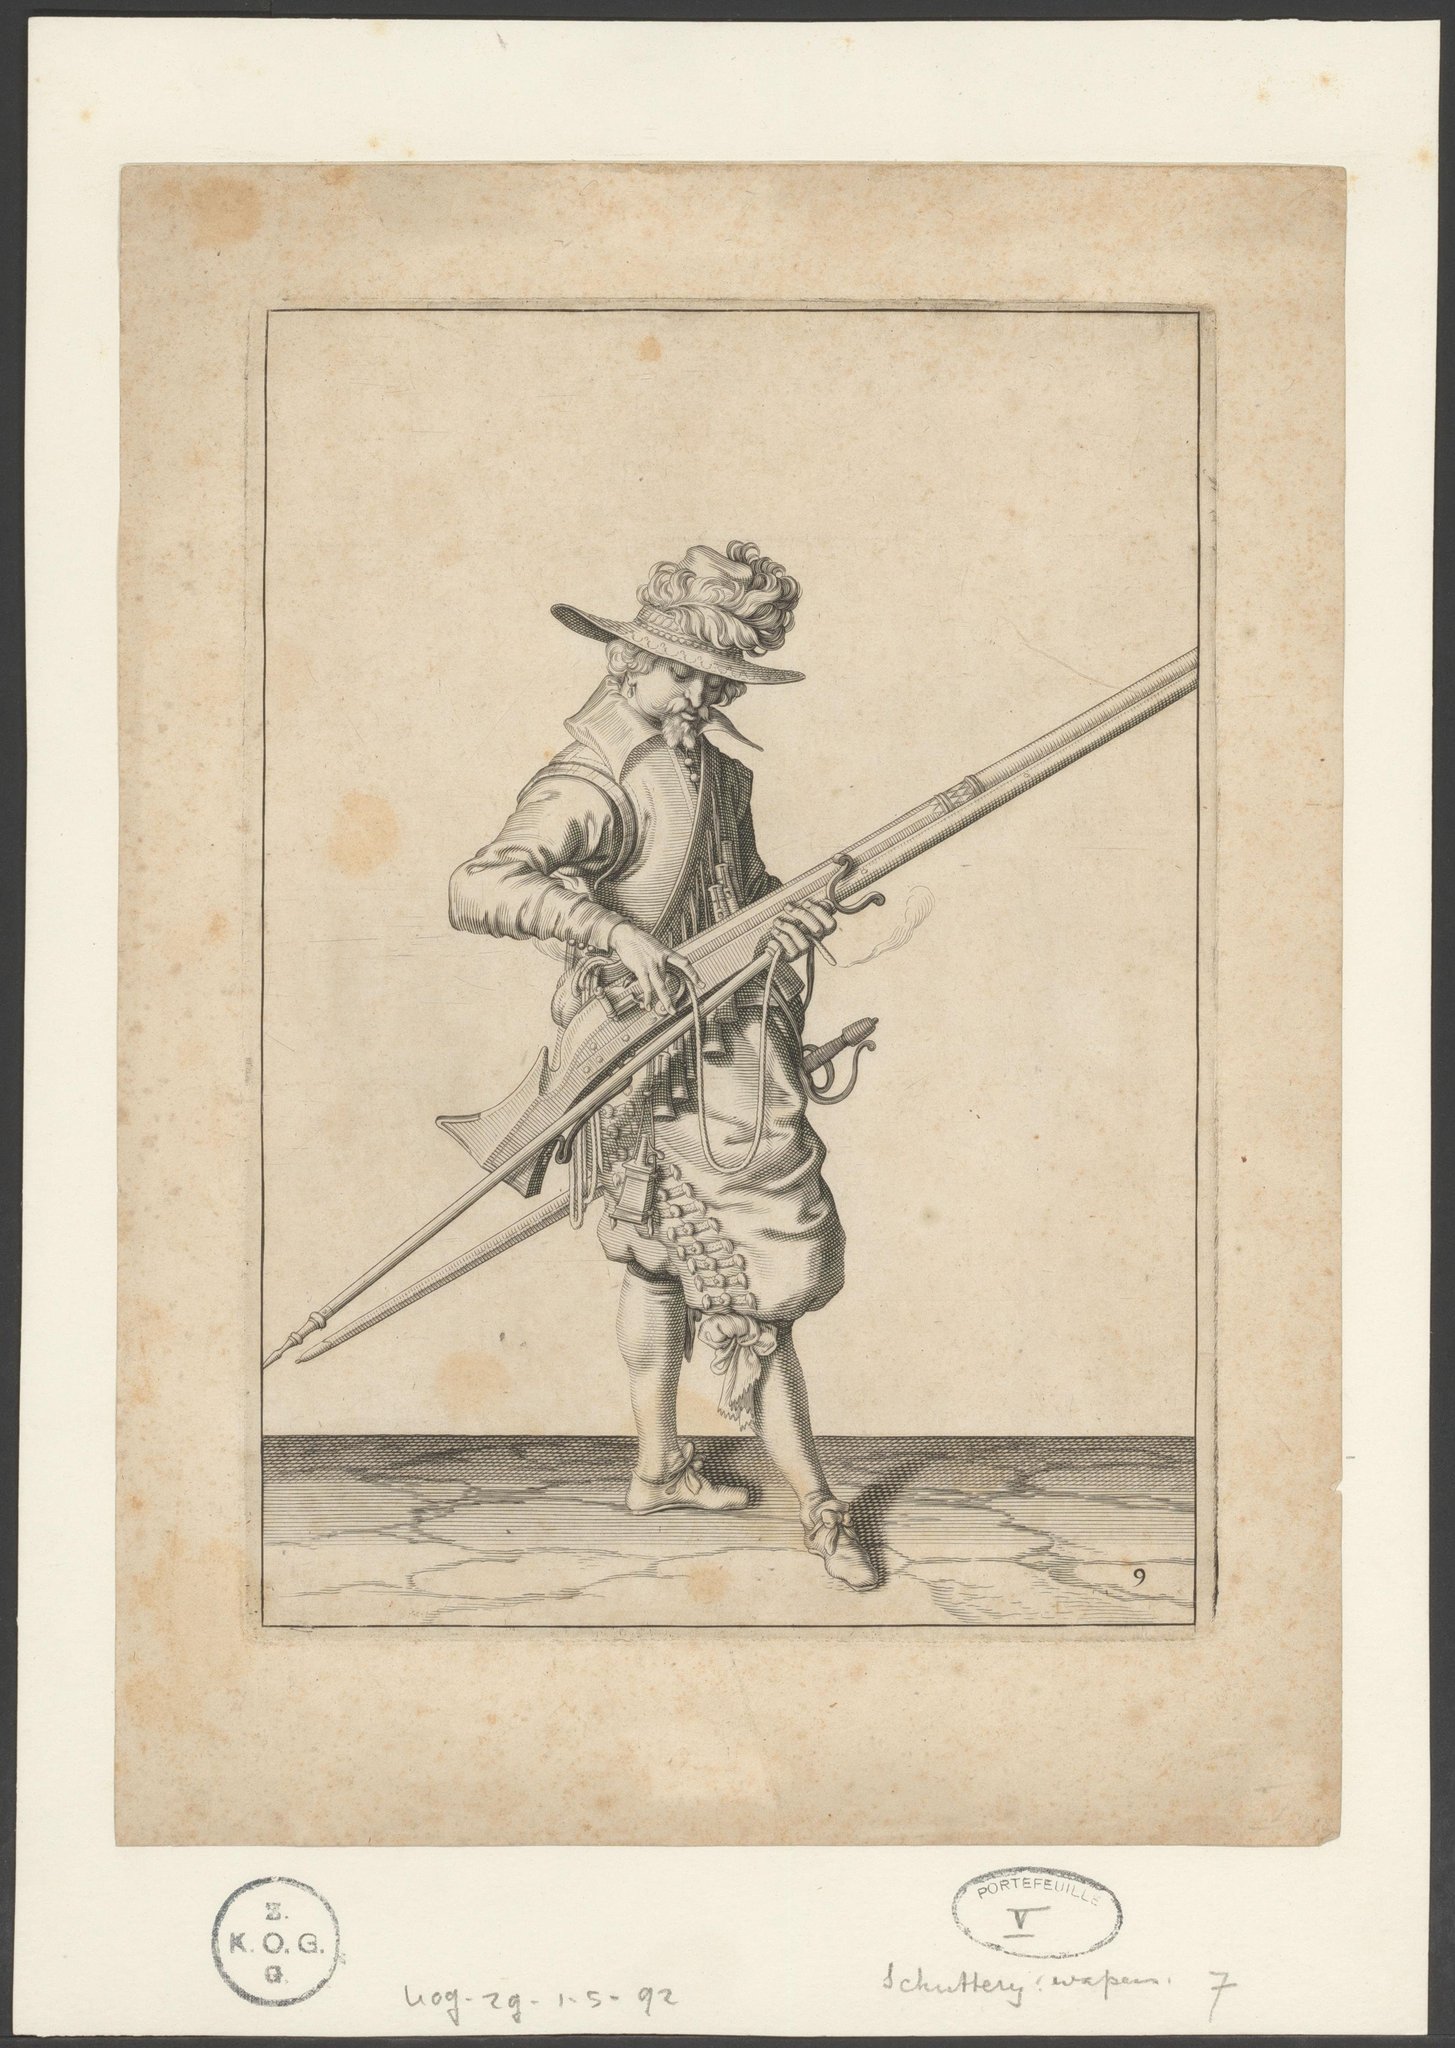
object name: print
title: Wapenhandelinghe van Roers Musquetten ende Spiessen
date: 1597-1607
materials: paper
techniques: engraving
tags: manoeuvre ~ military training, firearms: rifle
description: Een soldaat, ten voeten uit, naar rechts, die een musket (een bepaald type vuurwapen) met zijn linkerhand vasthoudt. Met duim en middelvinger van zijn rechterhand geeft hij de brandende lont op de haan (onderdeel van het ontstekingsmechanisme) van zijn musket de juiste plek en vorm. Deze prent is onderdeel van de reeks van 43 genummerde prenten van musketiers uit de Wapenhandelinghe. Onderwerpsrubrieken binnen de Atlas Zeden en Gewoonten: Krijgswezen, Wapens.